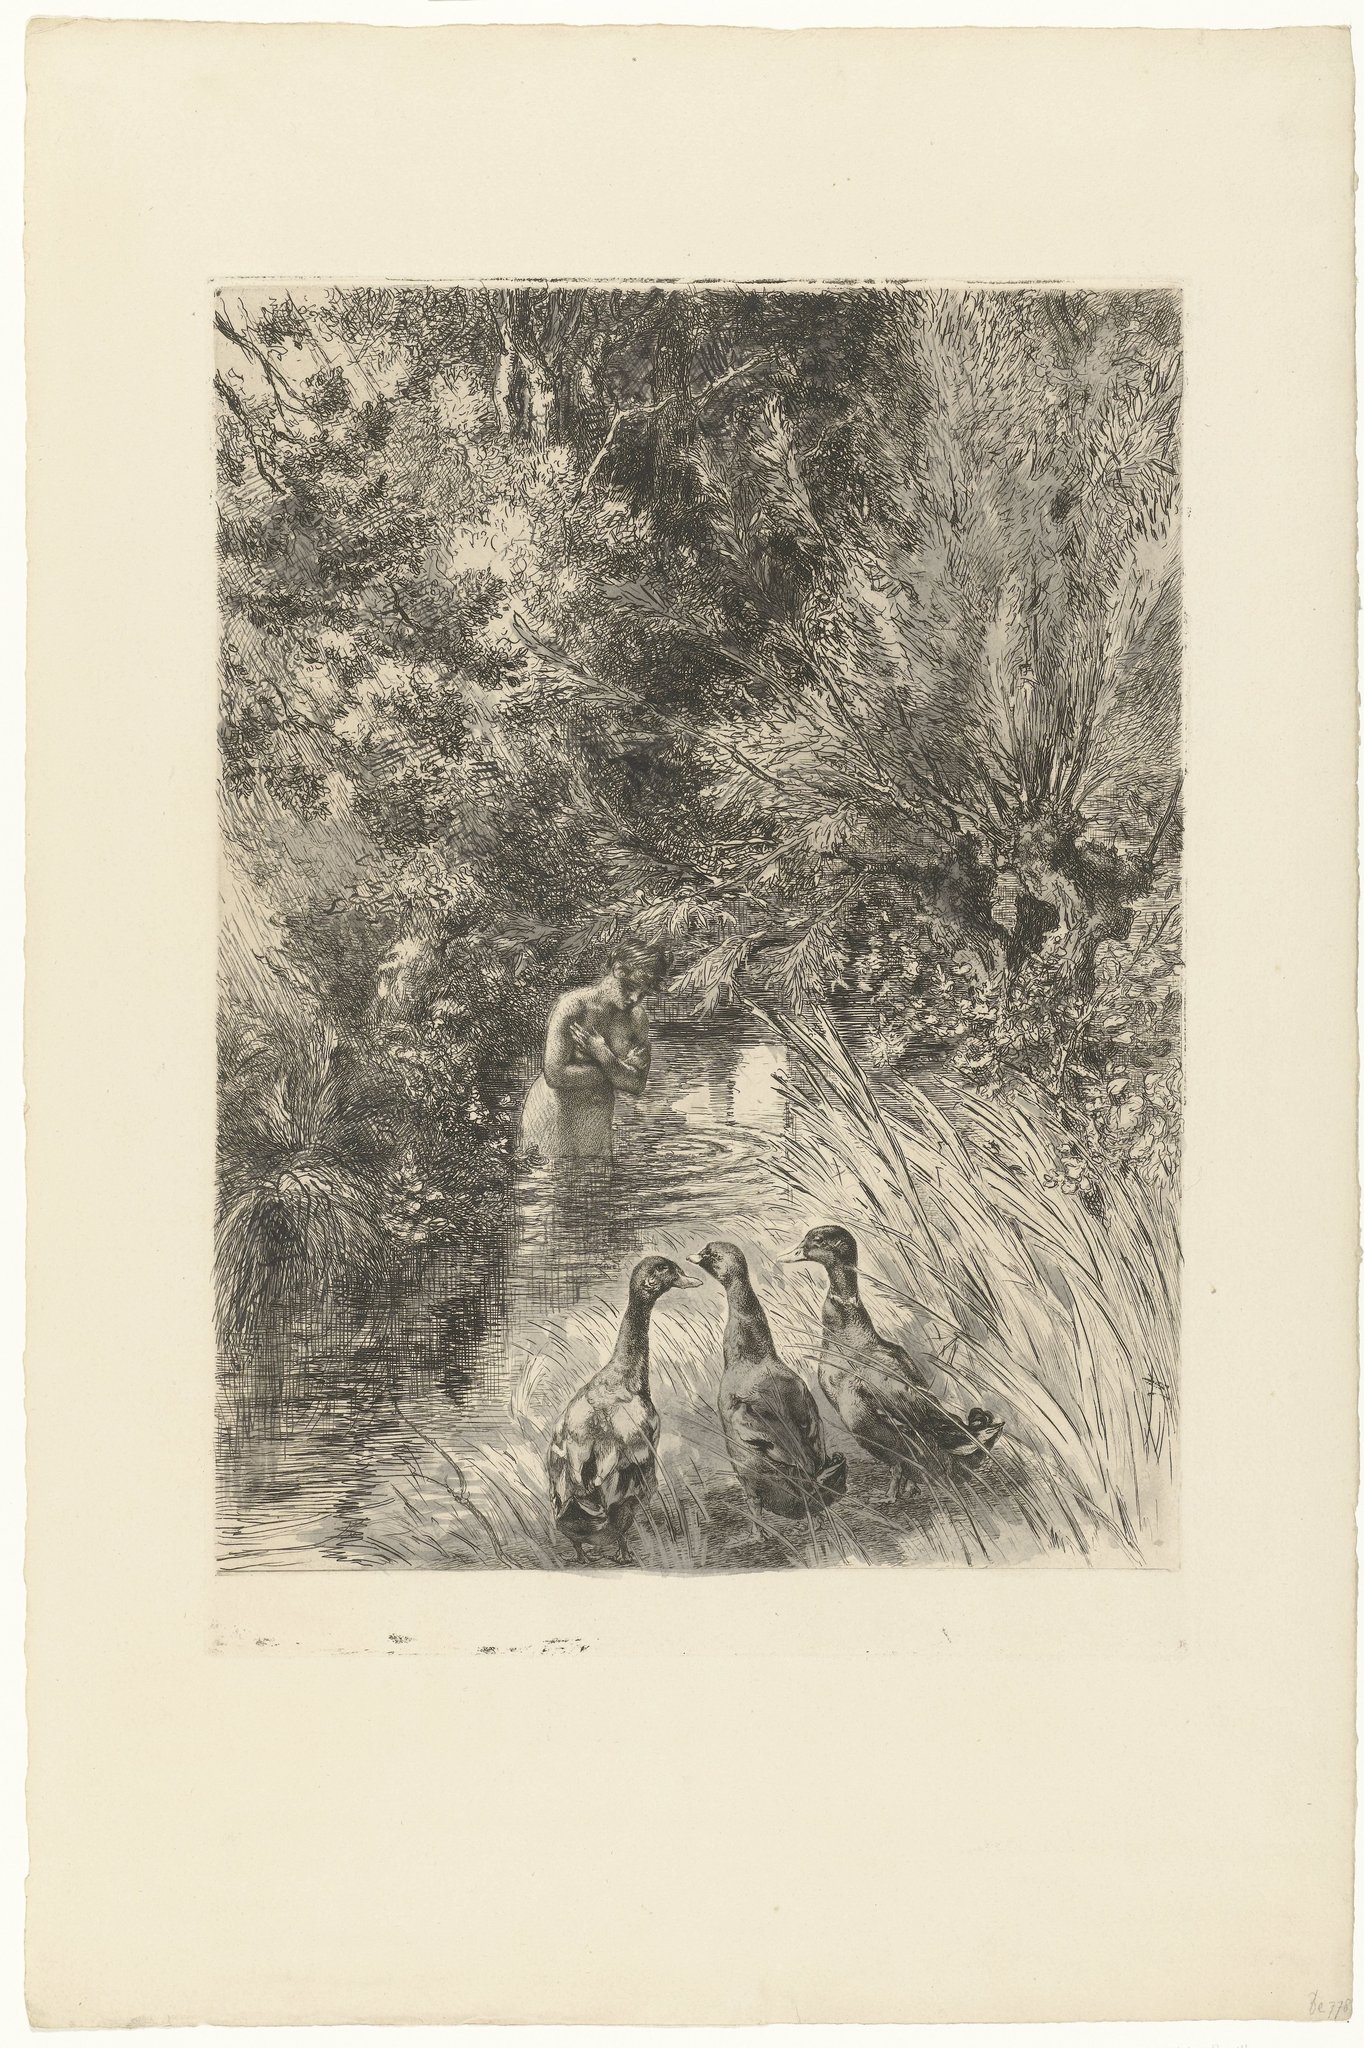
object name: print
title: Zes landschappen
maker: félix bracquemond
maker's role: print maker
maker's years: 1833-1914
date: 1882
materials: chalk, ink, paper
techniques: brush, etching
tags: female sex; woman, washing and bathing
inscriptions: collector's mark: Lugt 2228, collector's mark: Lugt 2760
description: Een naakte vrouw baadt zich in water onder de beschutting van bomen op de oever. Drie eenden staan tussen het hoge gras op de oever op de voorgrond. Proefdruk met aanpassingen van de kunstenaar in pen en penseel in grijs en zwart.